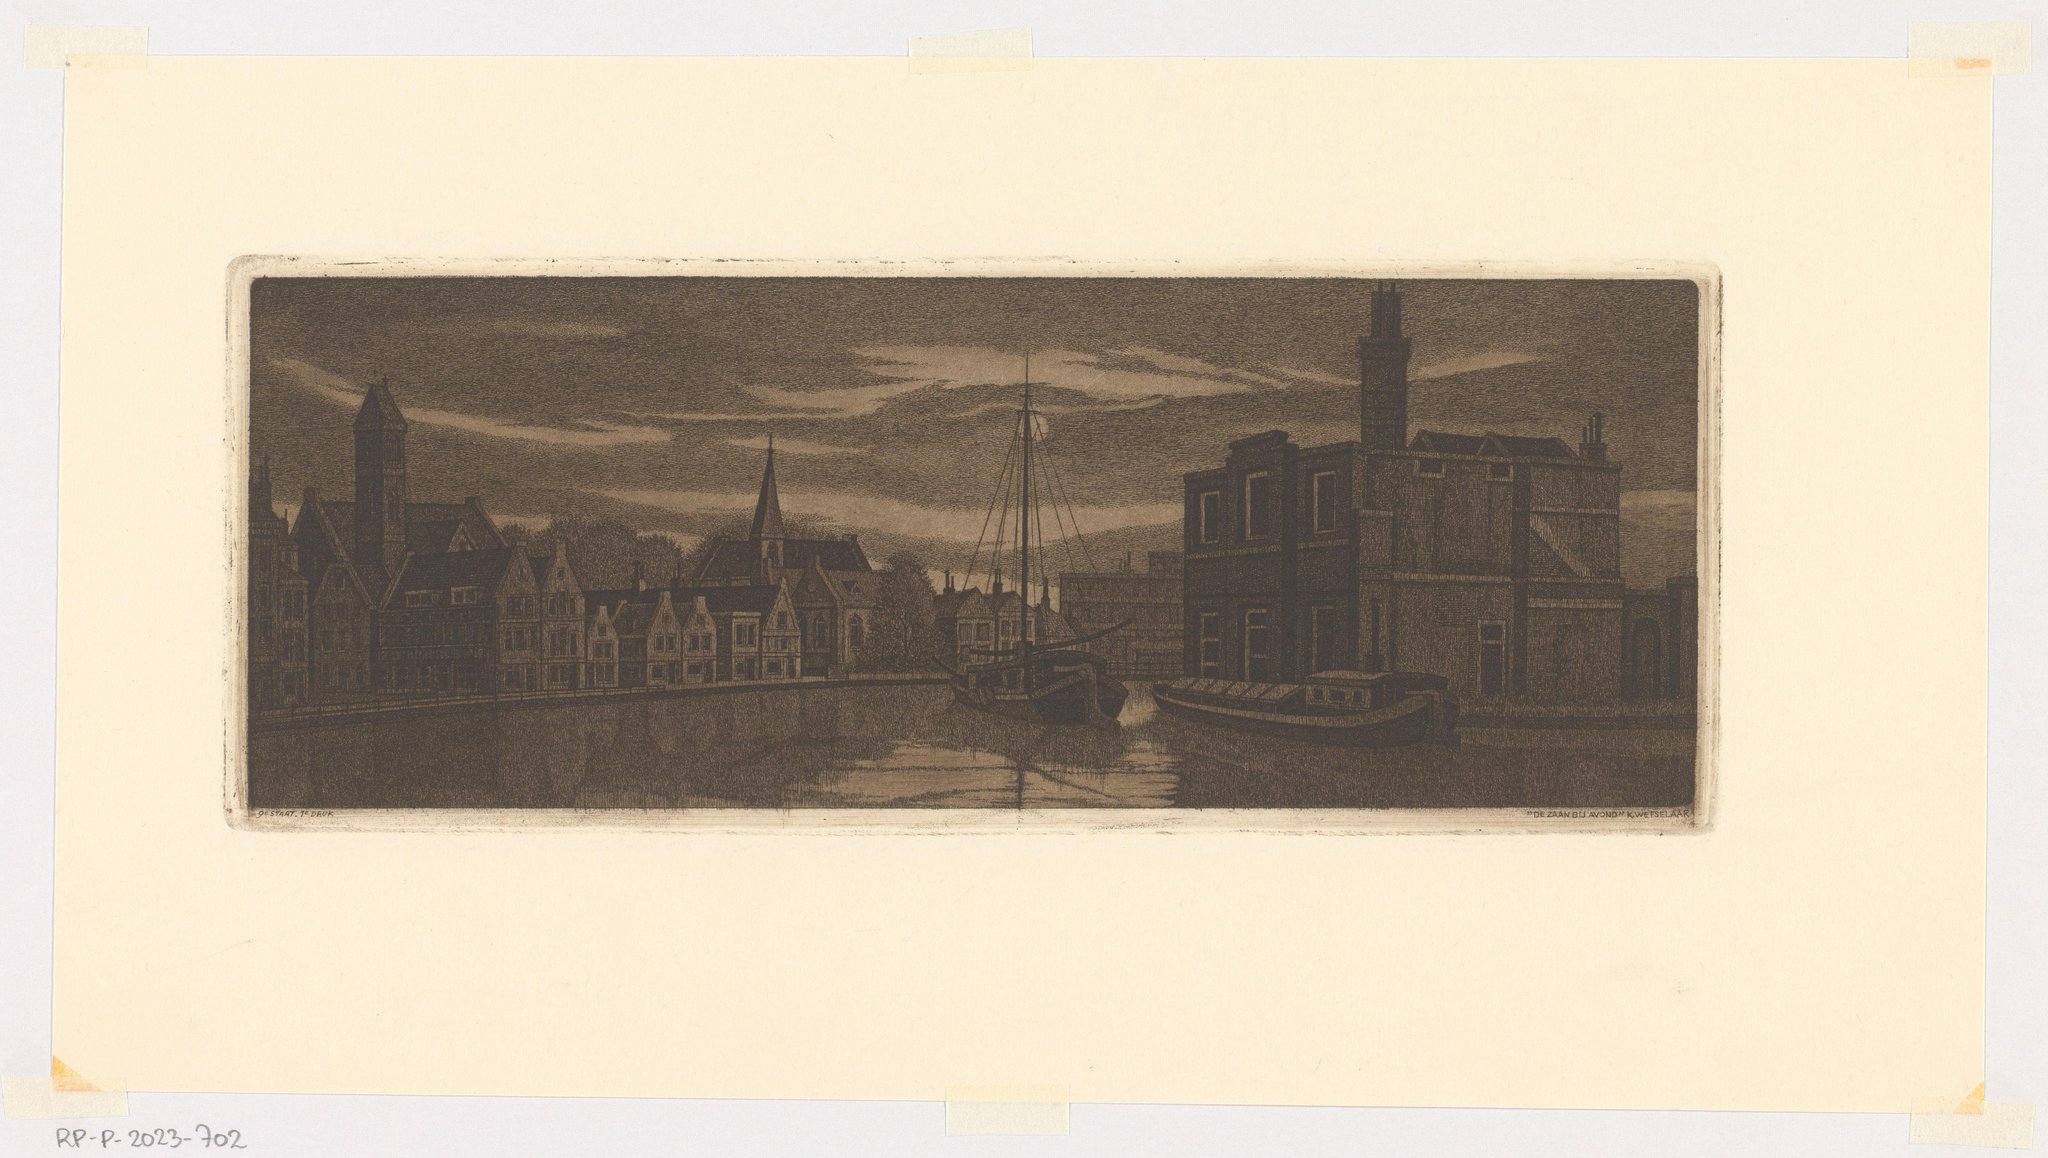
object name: print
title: De Zaan bij Avond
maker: karel wetselaar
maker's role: print maker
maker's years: 1935-2017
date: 1989-1990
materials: paper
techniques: etching, intaglio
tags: river, village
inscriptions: inscription: ‘9e staat, 1e druk’, signature: ‘K. Wetselaar’